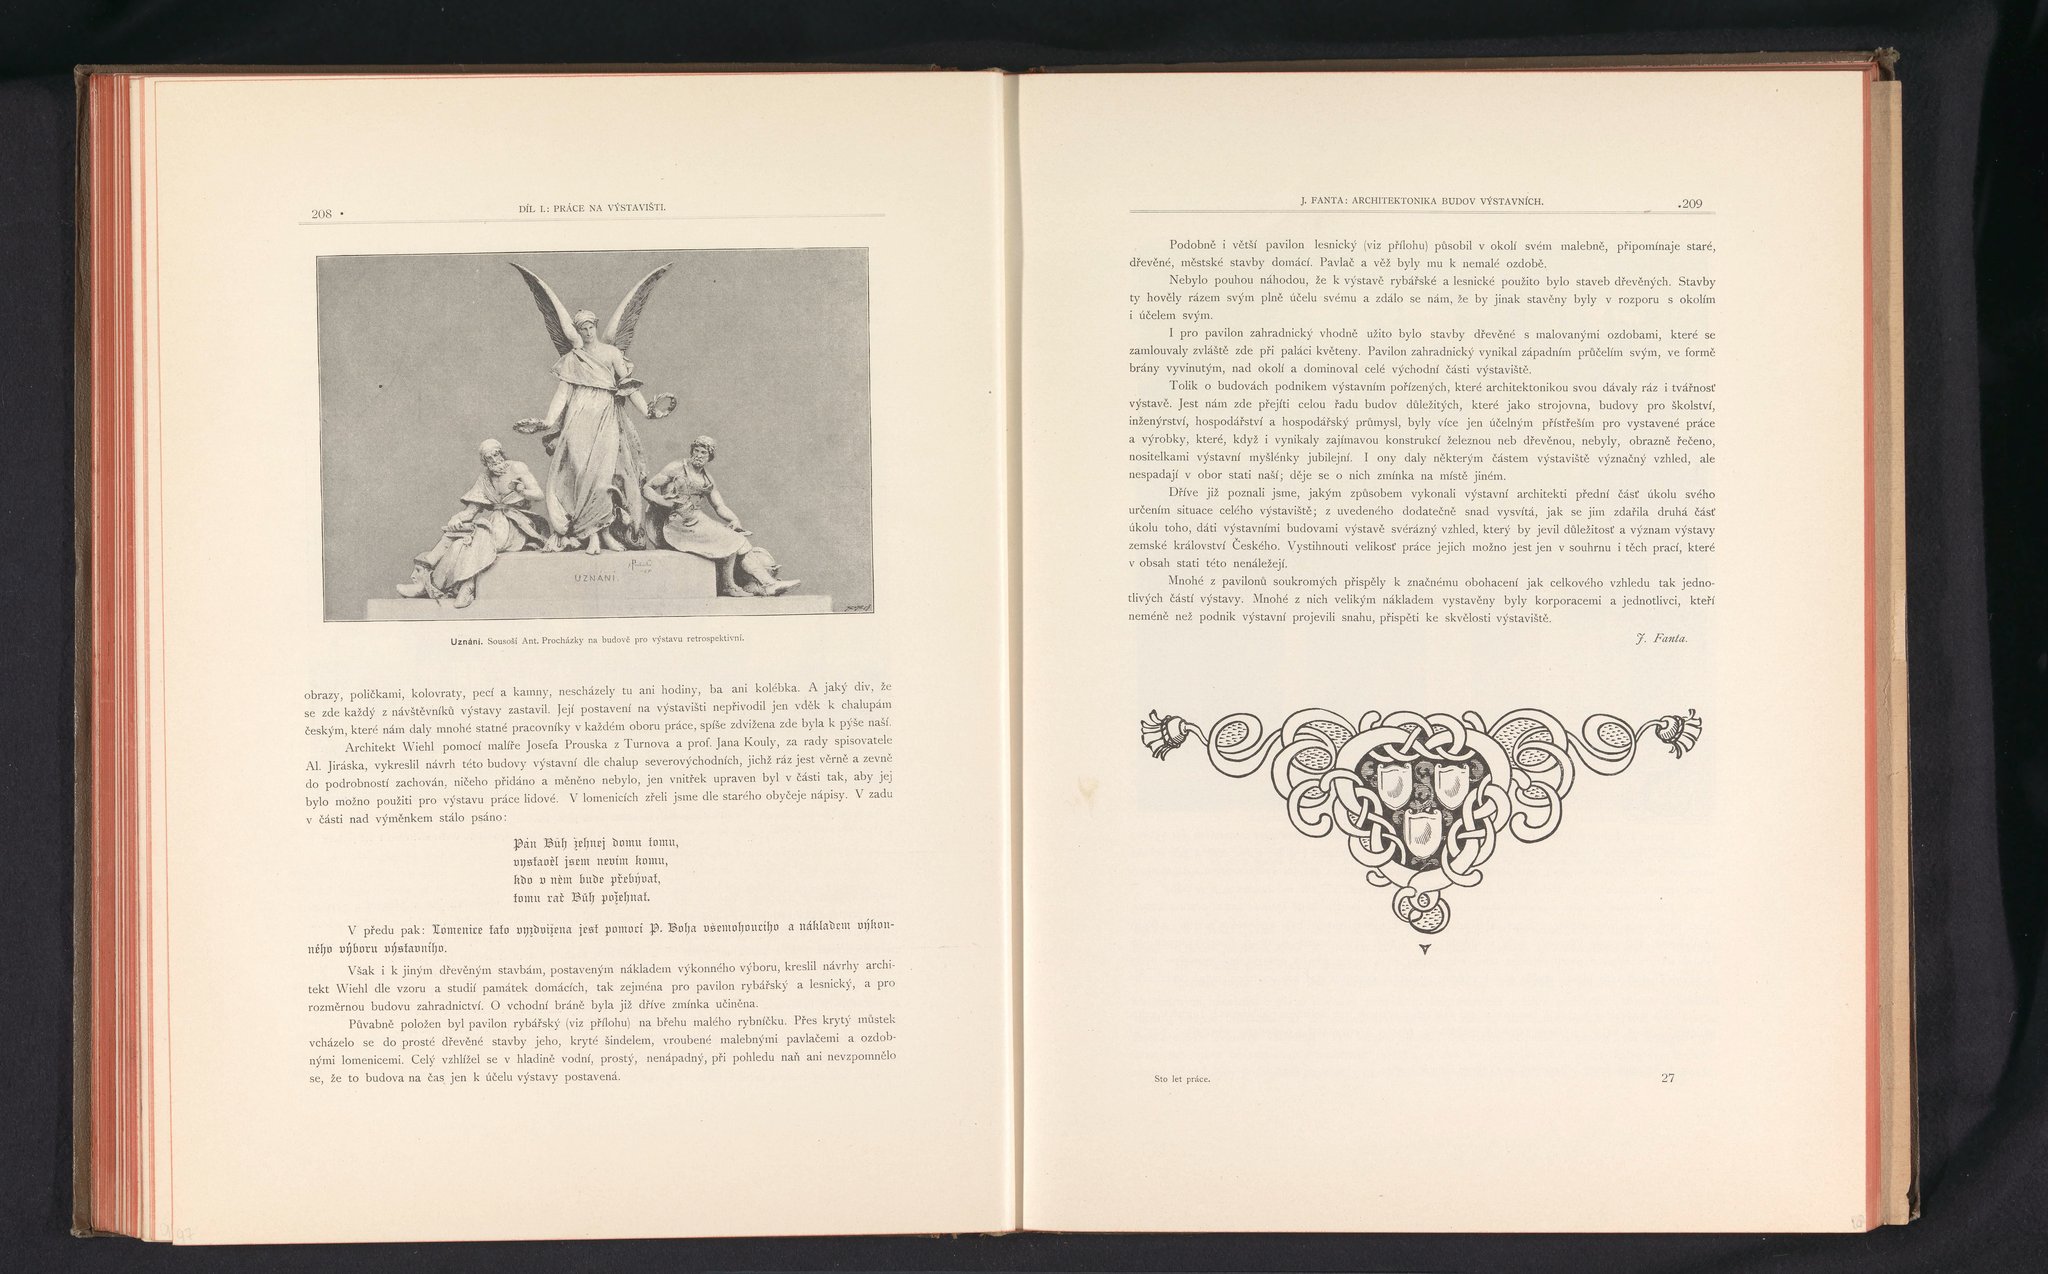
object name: photomechanical print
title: Uznani. Sousosi Ant. Procházky na budove pro výstavu retrospektivni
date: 1891-1893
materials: paper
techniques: autotype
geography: prague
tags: monument, statue, sculpture